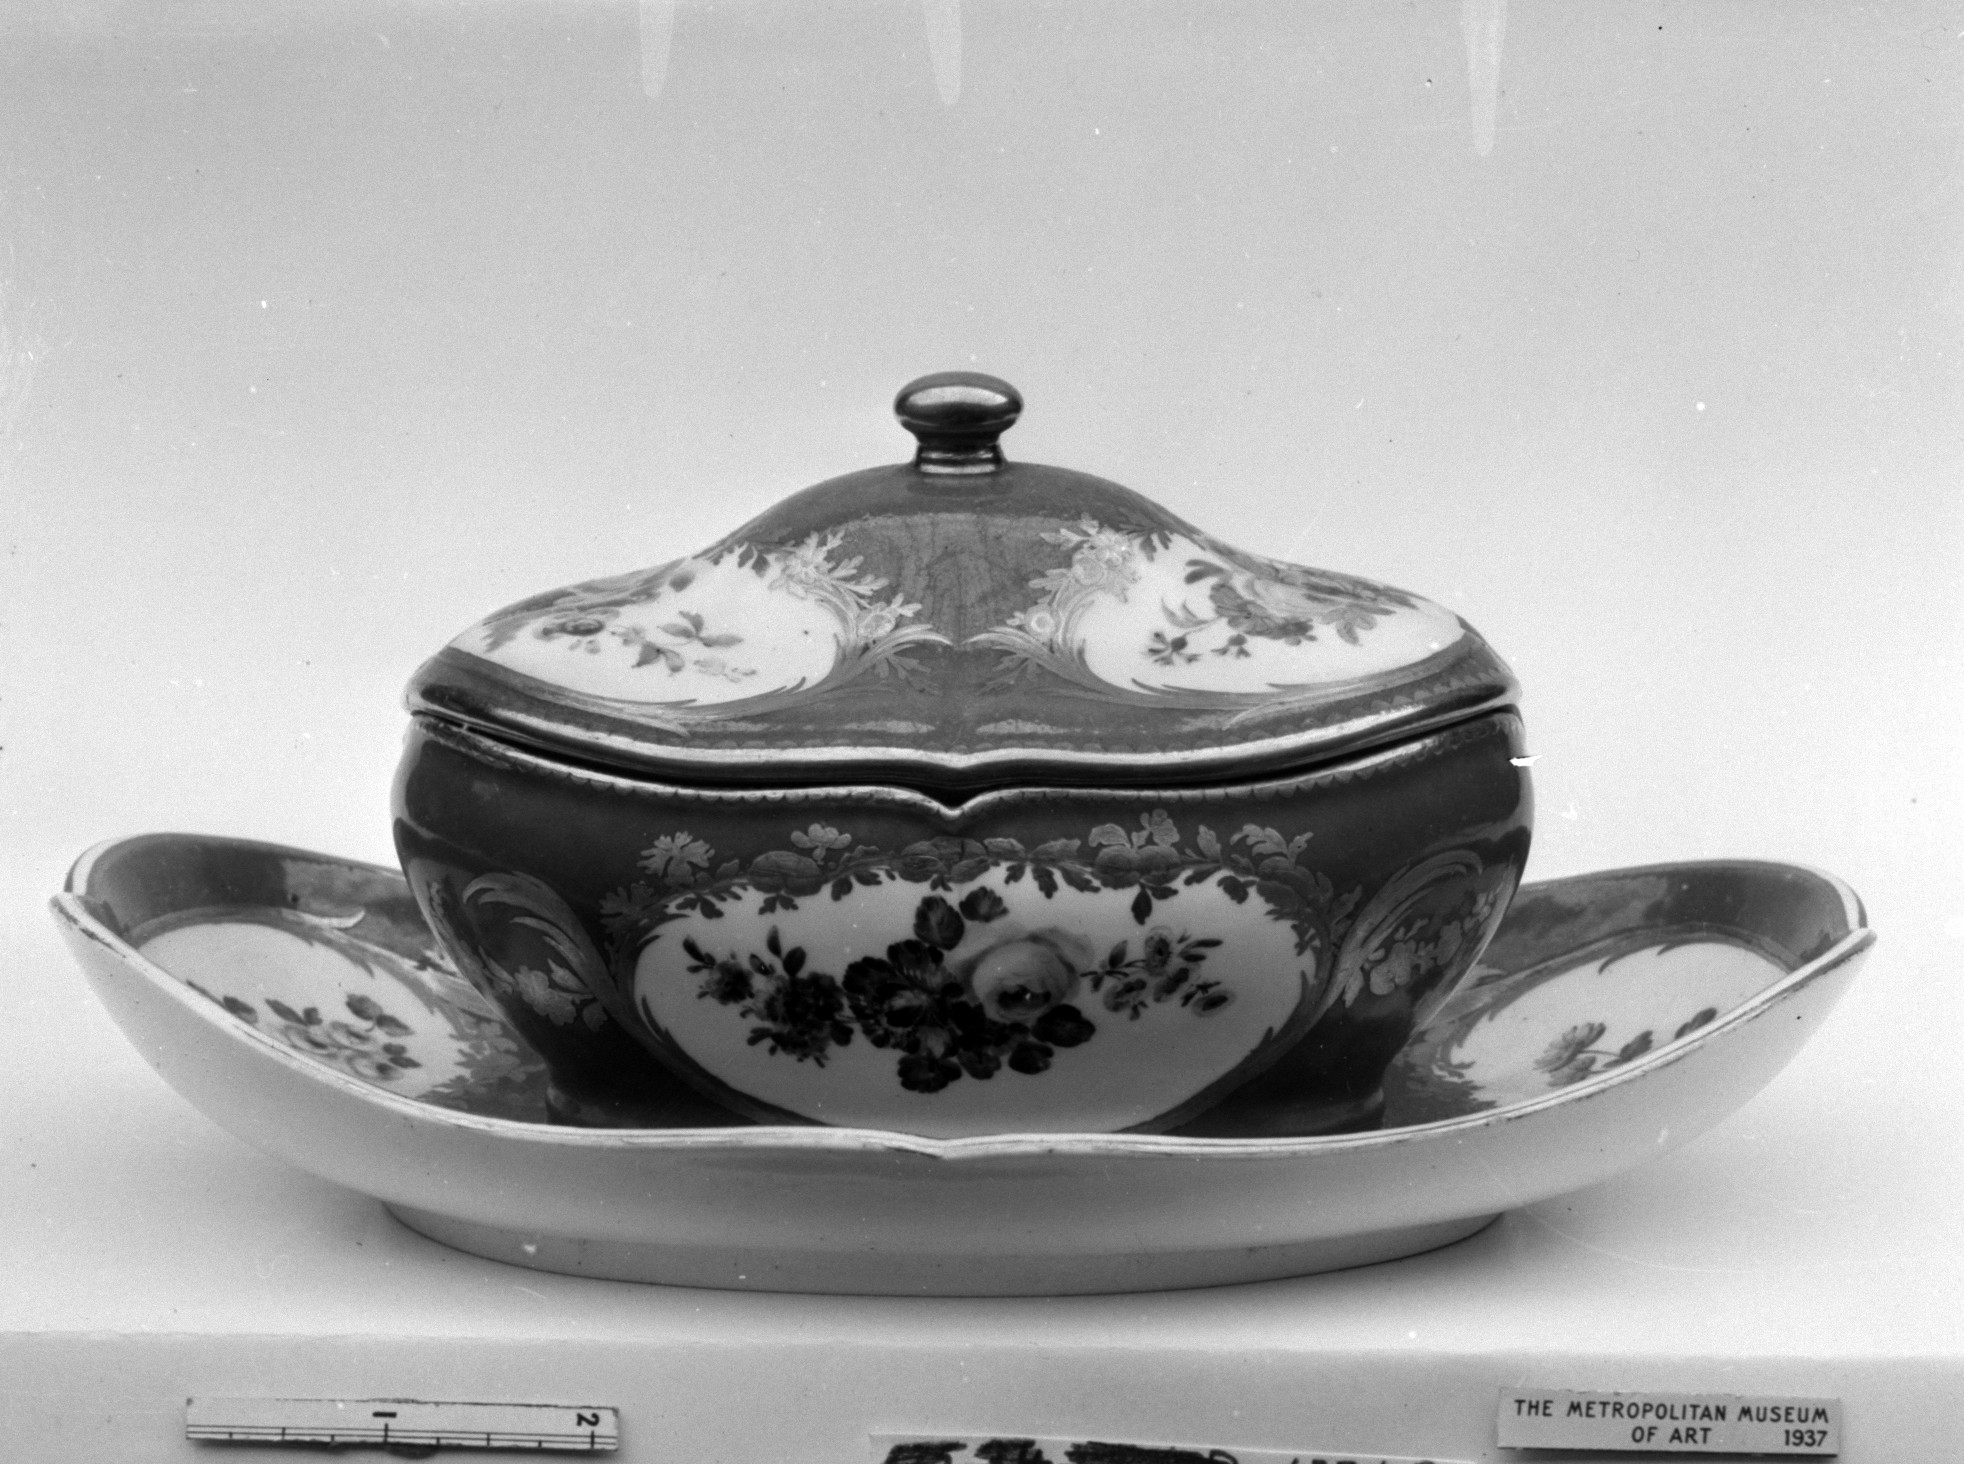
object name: sugar bowl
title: Sugar bowl (one of four) (part of a service)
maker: sèvres manufactory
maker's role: manufactory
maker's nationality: french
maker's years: 1740-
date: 1767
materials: soft paste porcelain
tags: flowers